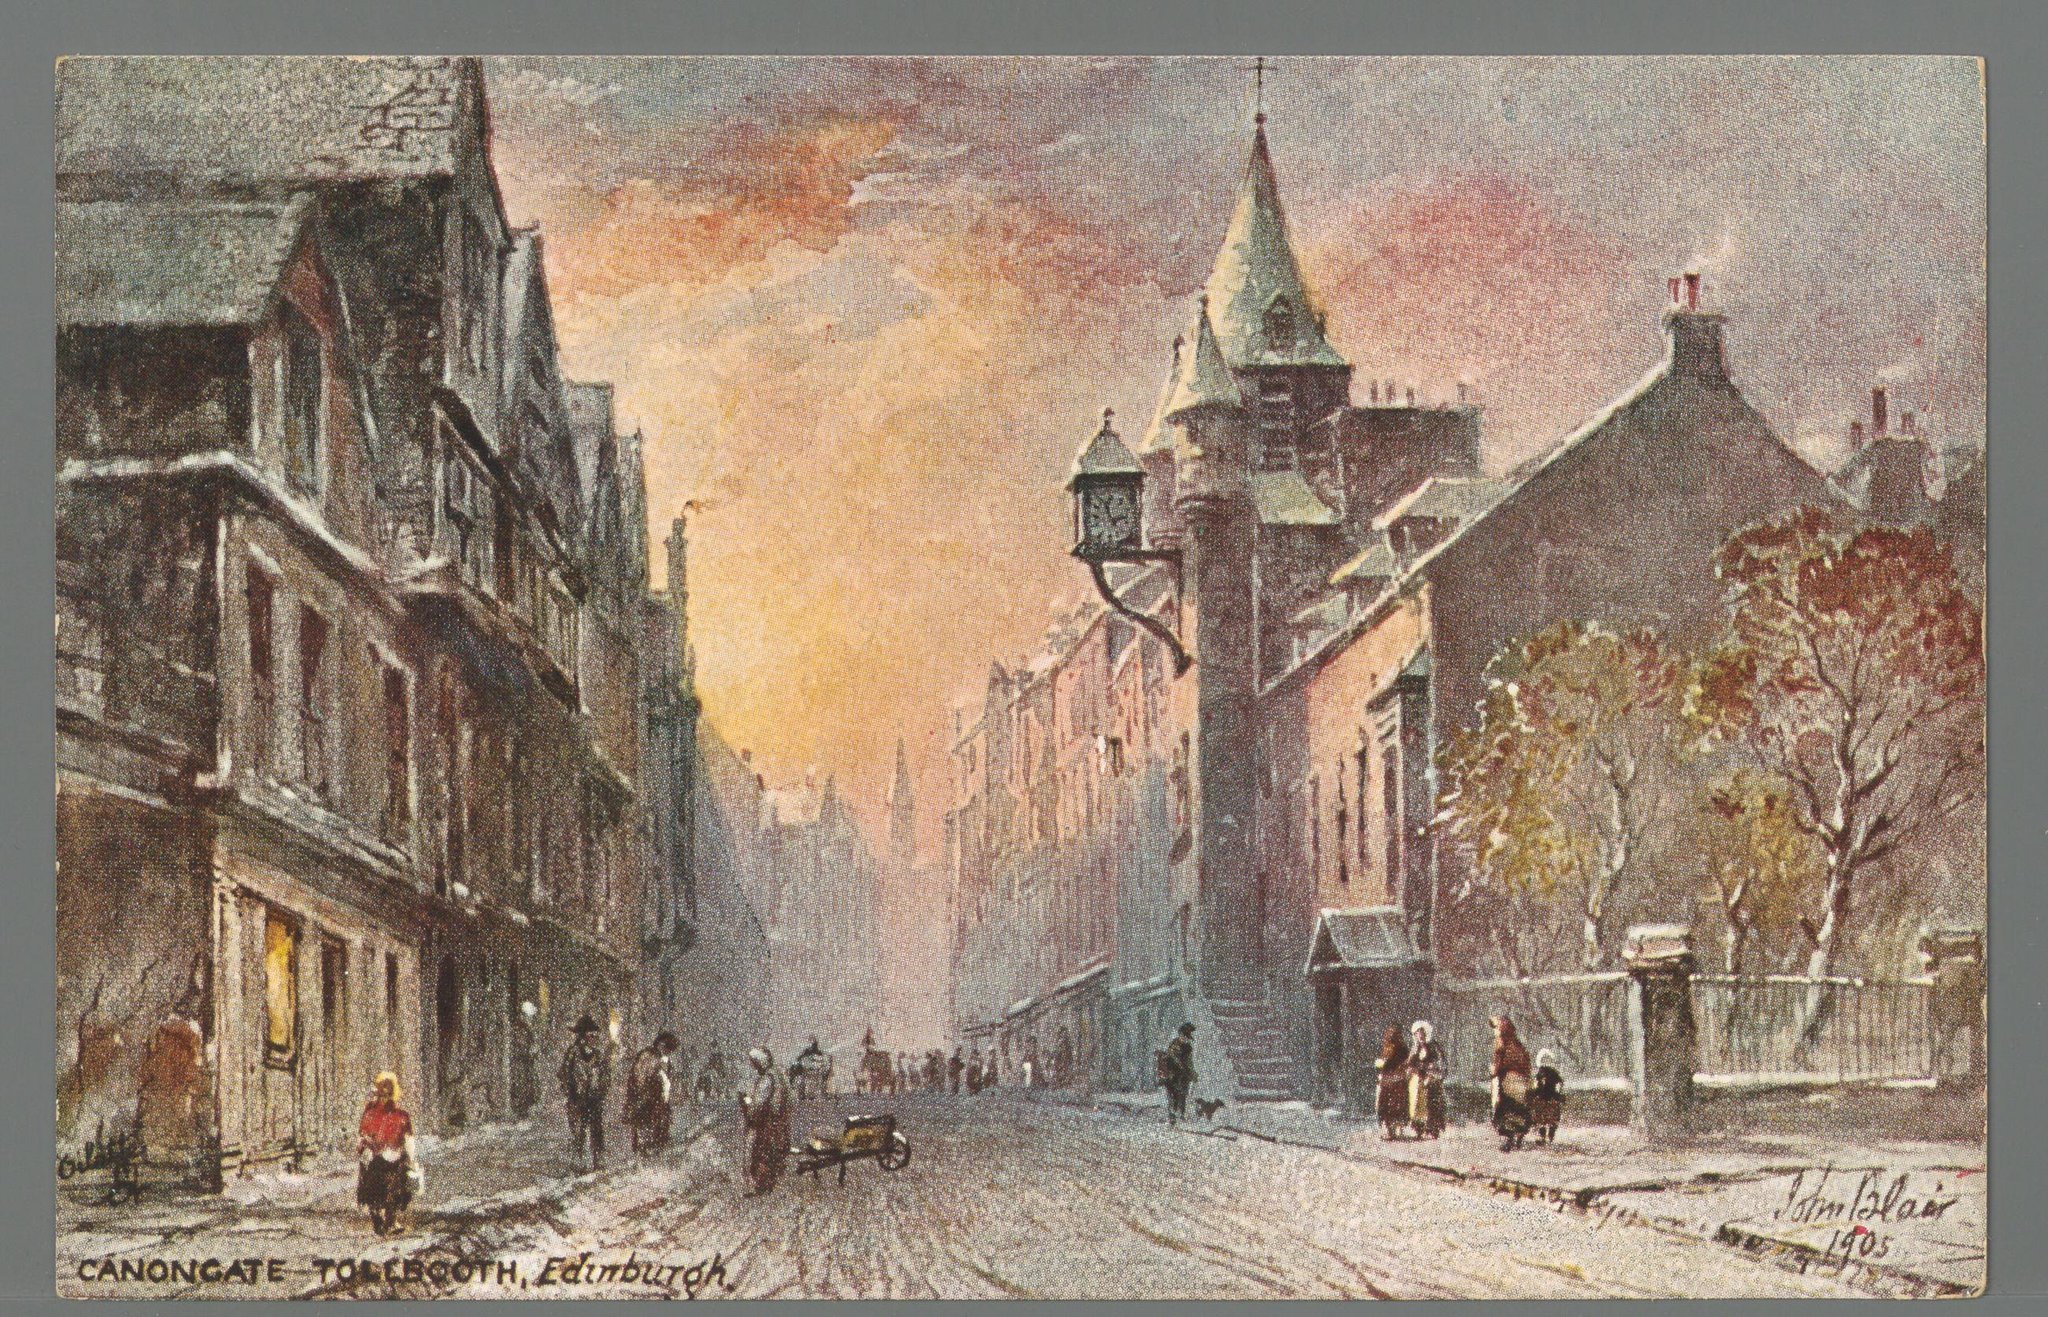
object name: ansichtkaart, prentbriefkaart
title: Canongate Tolebooth, Edinburgh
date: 1905-1912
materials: cardboard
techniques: color autotype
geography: london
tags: monument, statue, street